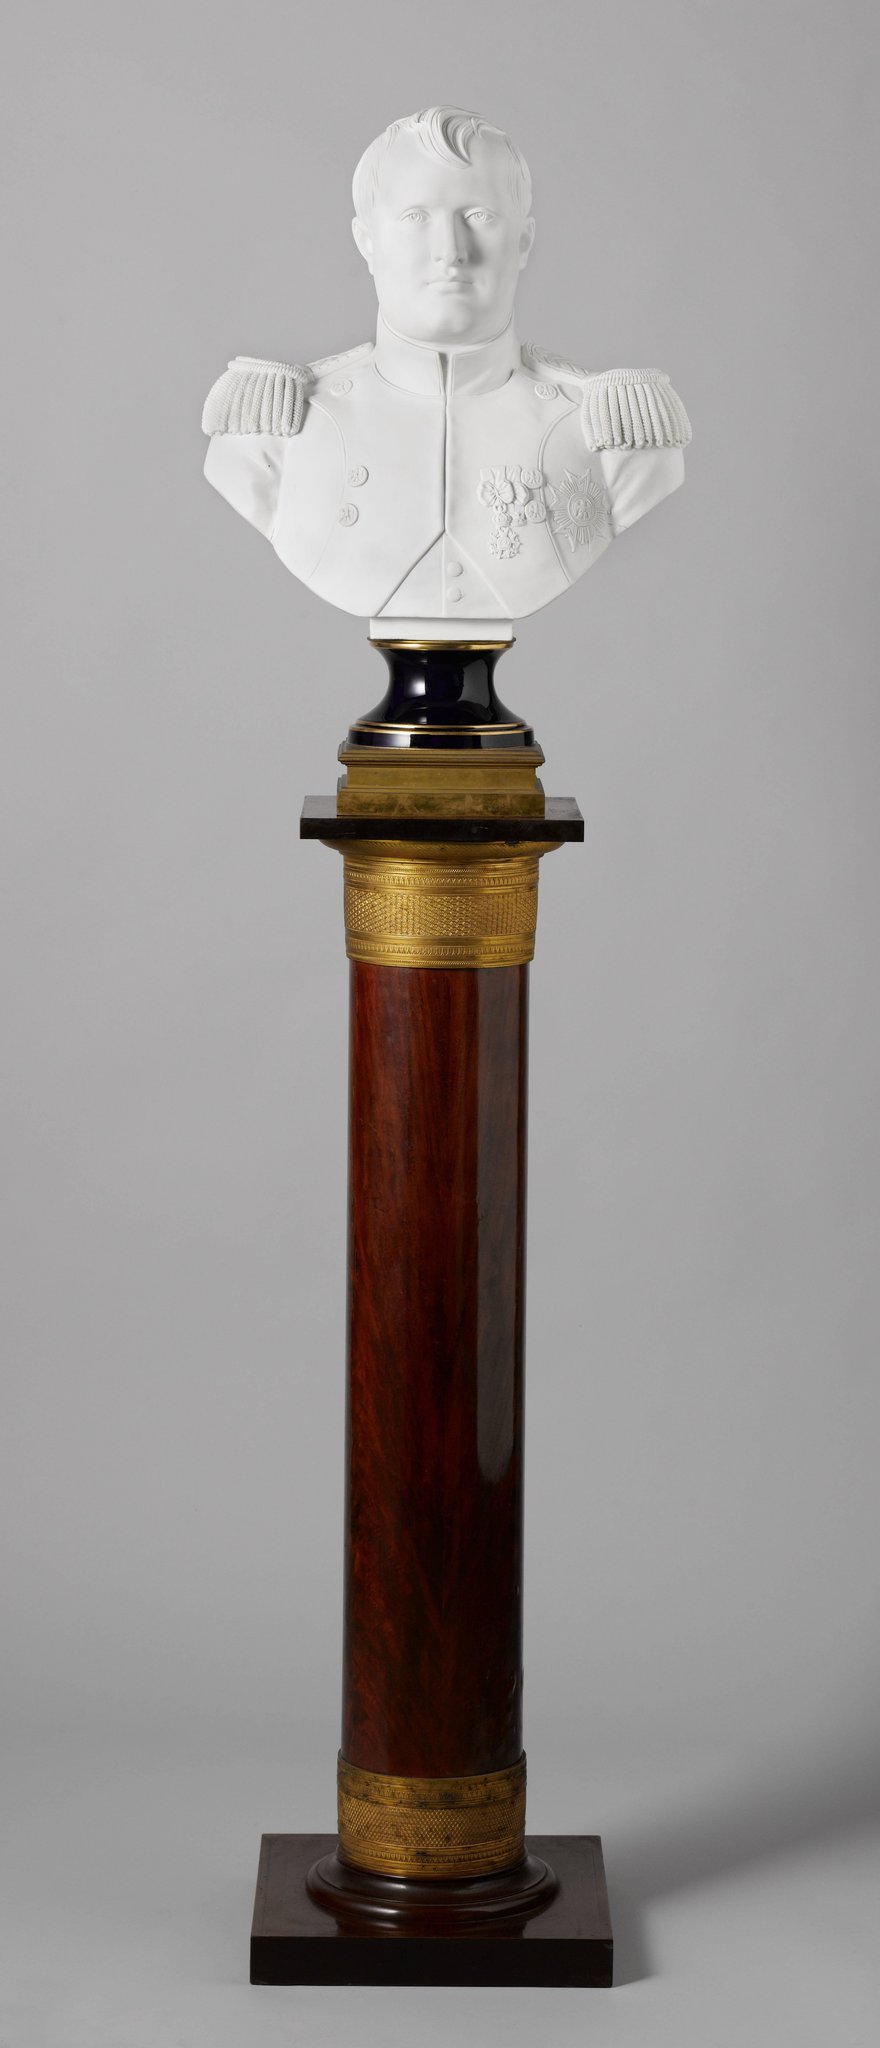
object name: column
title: Buste van biscuit, voorstellende Napoleon Bonaparte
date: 1805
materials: bronze, copper, wood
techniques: gilding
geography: sèvres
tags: napoleon i (emperor of the french), france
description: Zuil van gefineerd mahoniehout, staande op forse vierkante basis, waarboven een geprofileerde basisring van massief mahonie; de schacht heeft vergulde geciseleerde brede bronzen ringen aan boven en beneden einde en boven een bolle kwart ronde koperen afsluiting een vierkant massief mahoniehouten abaleus.